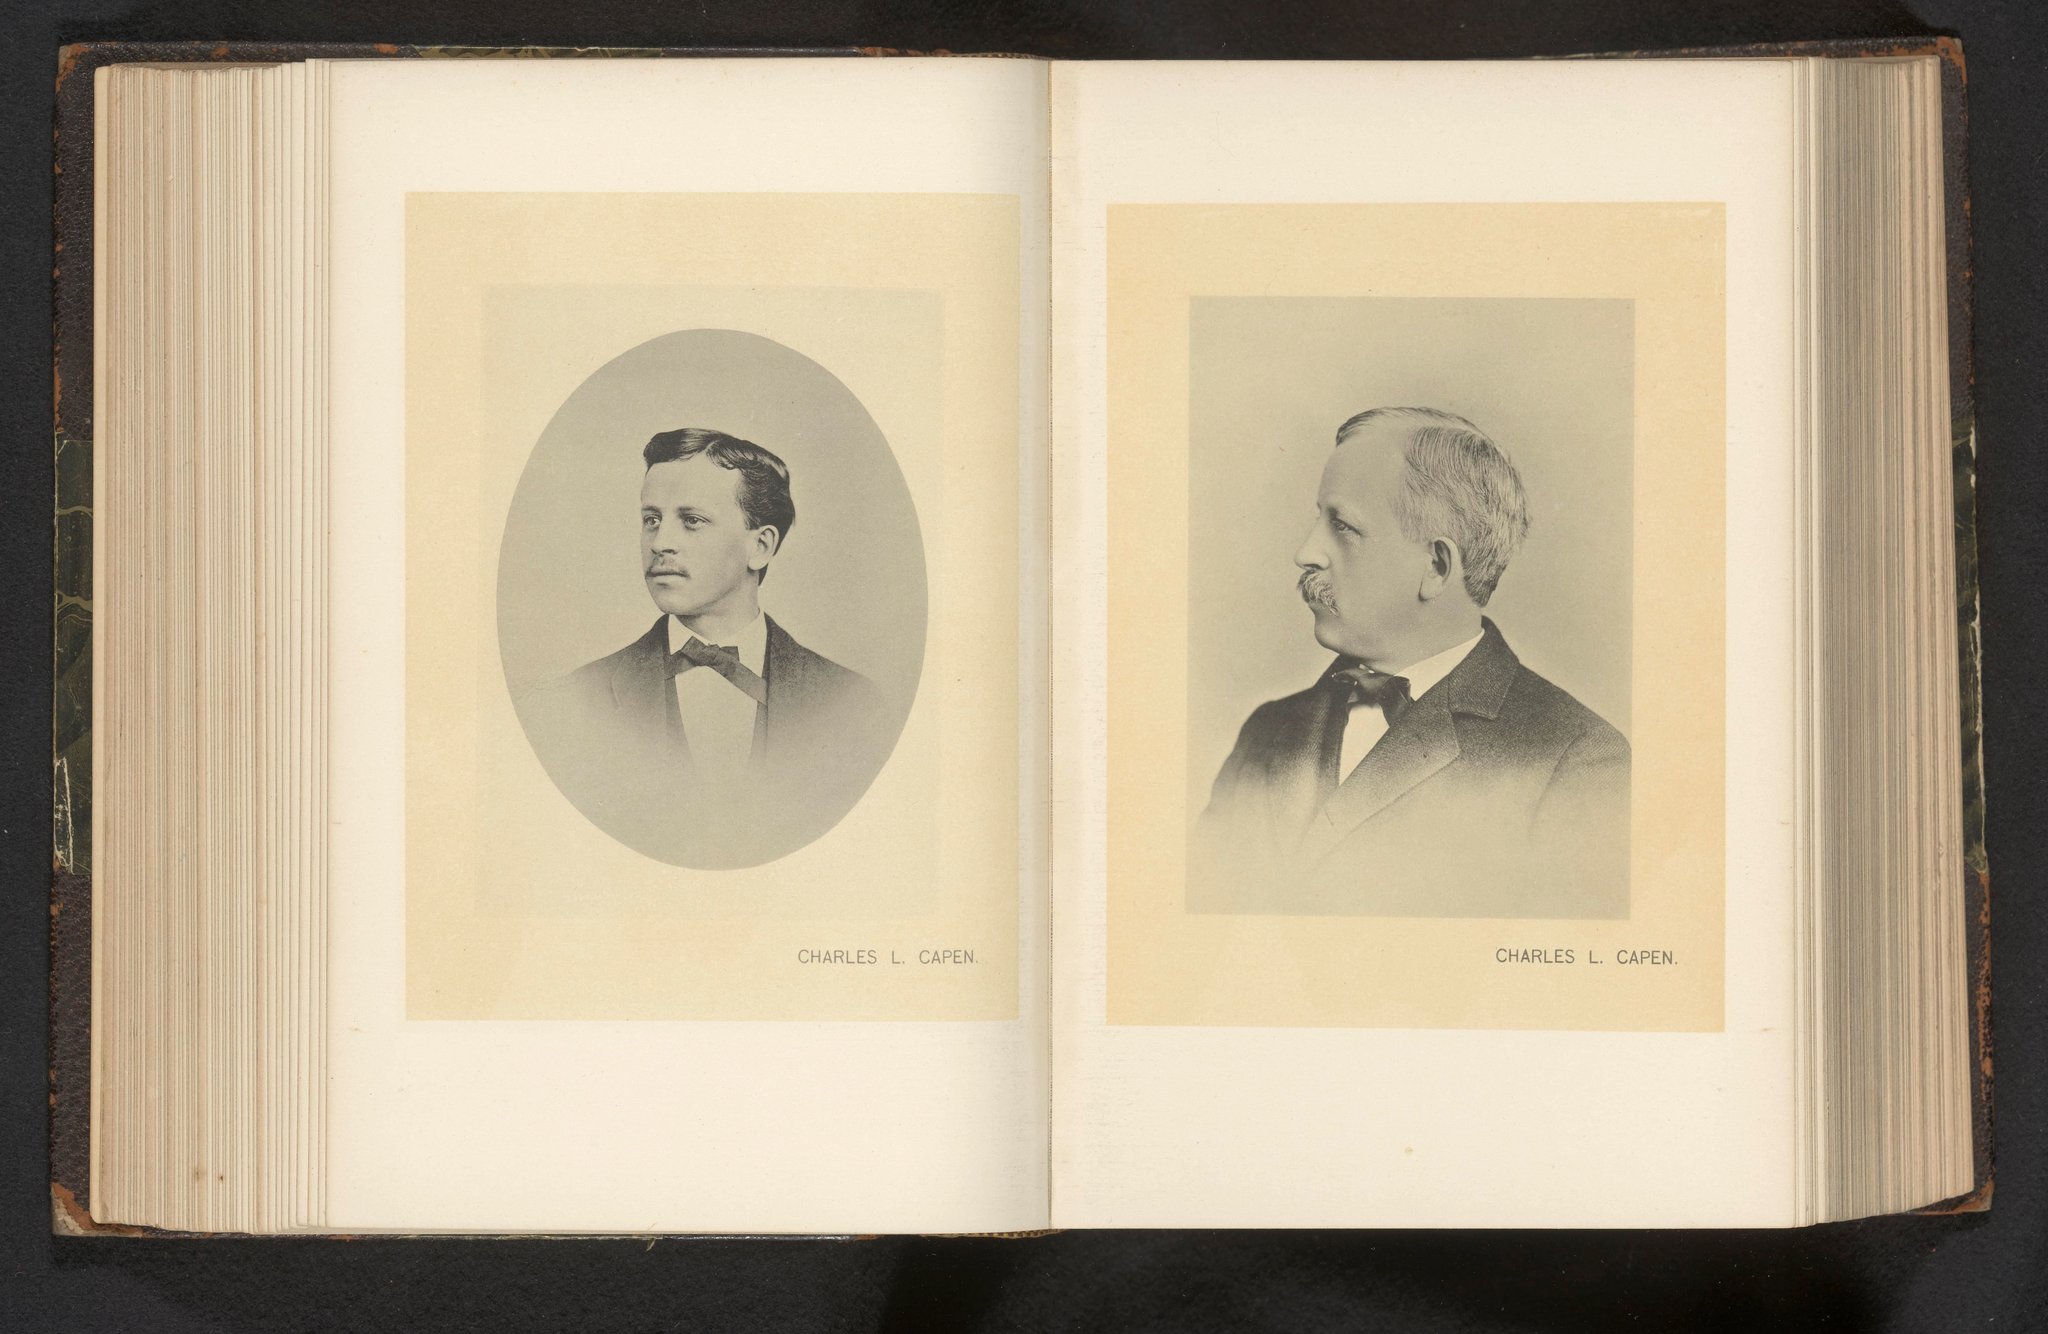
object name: page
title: Charles L. Capen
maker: Anonymous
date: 1869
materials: paper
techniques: photoaquatint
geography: boston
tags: lawyer, attorney at law